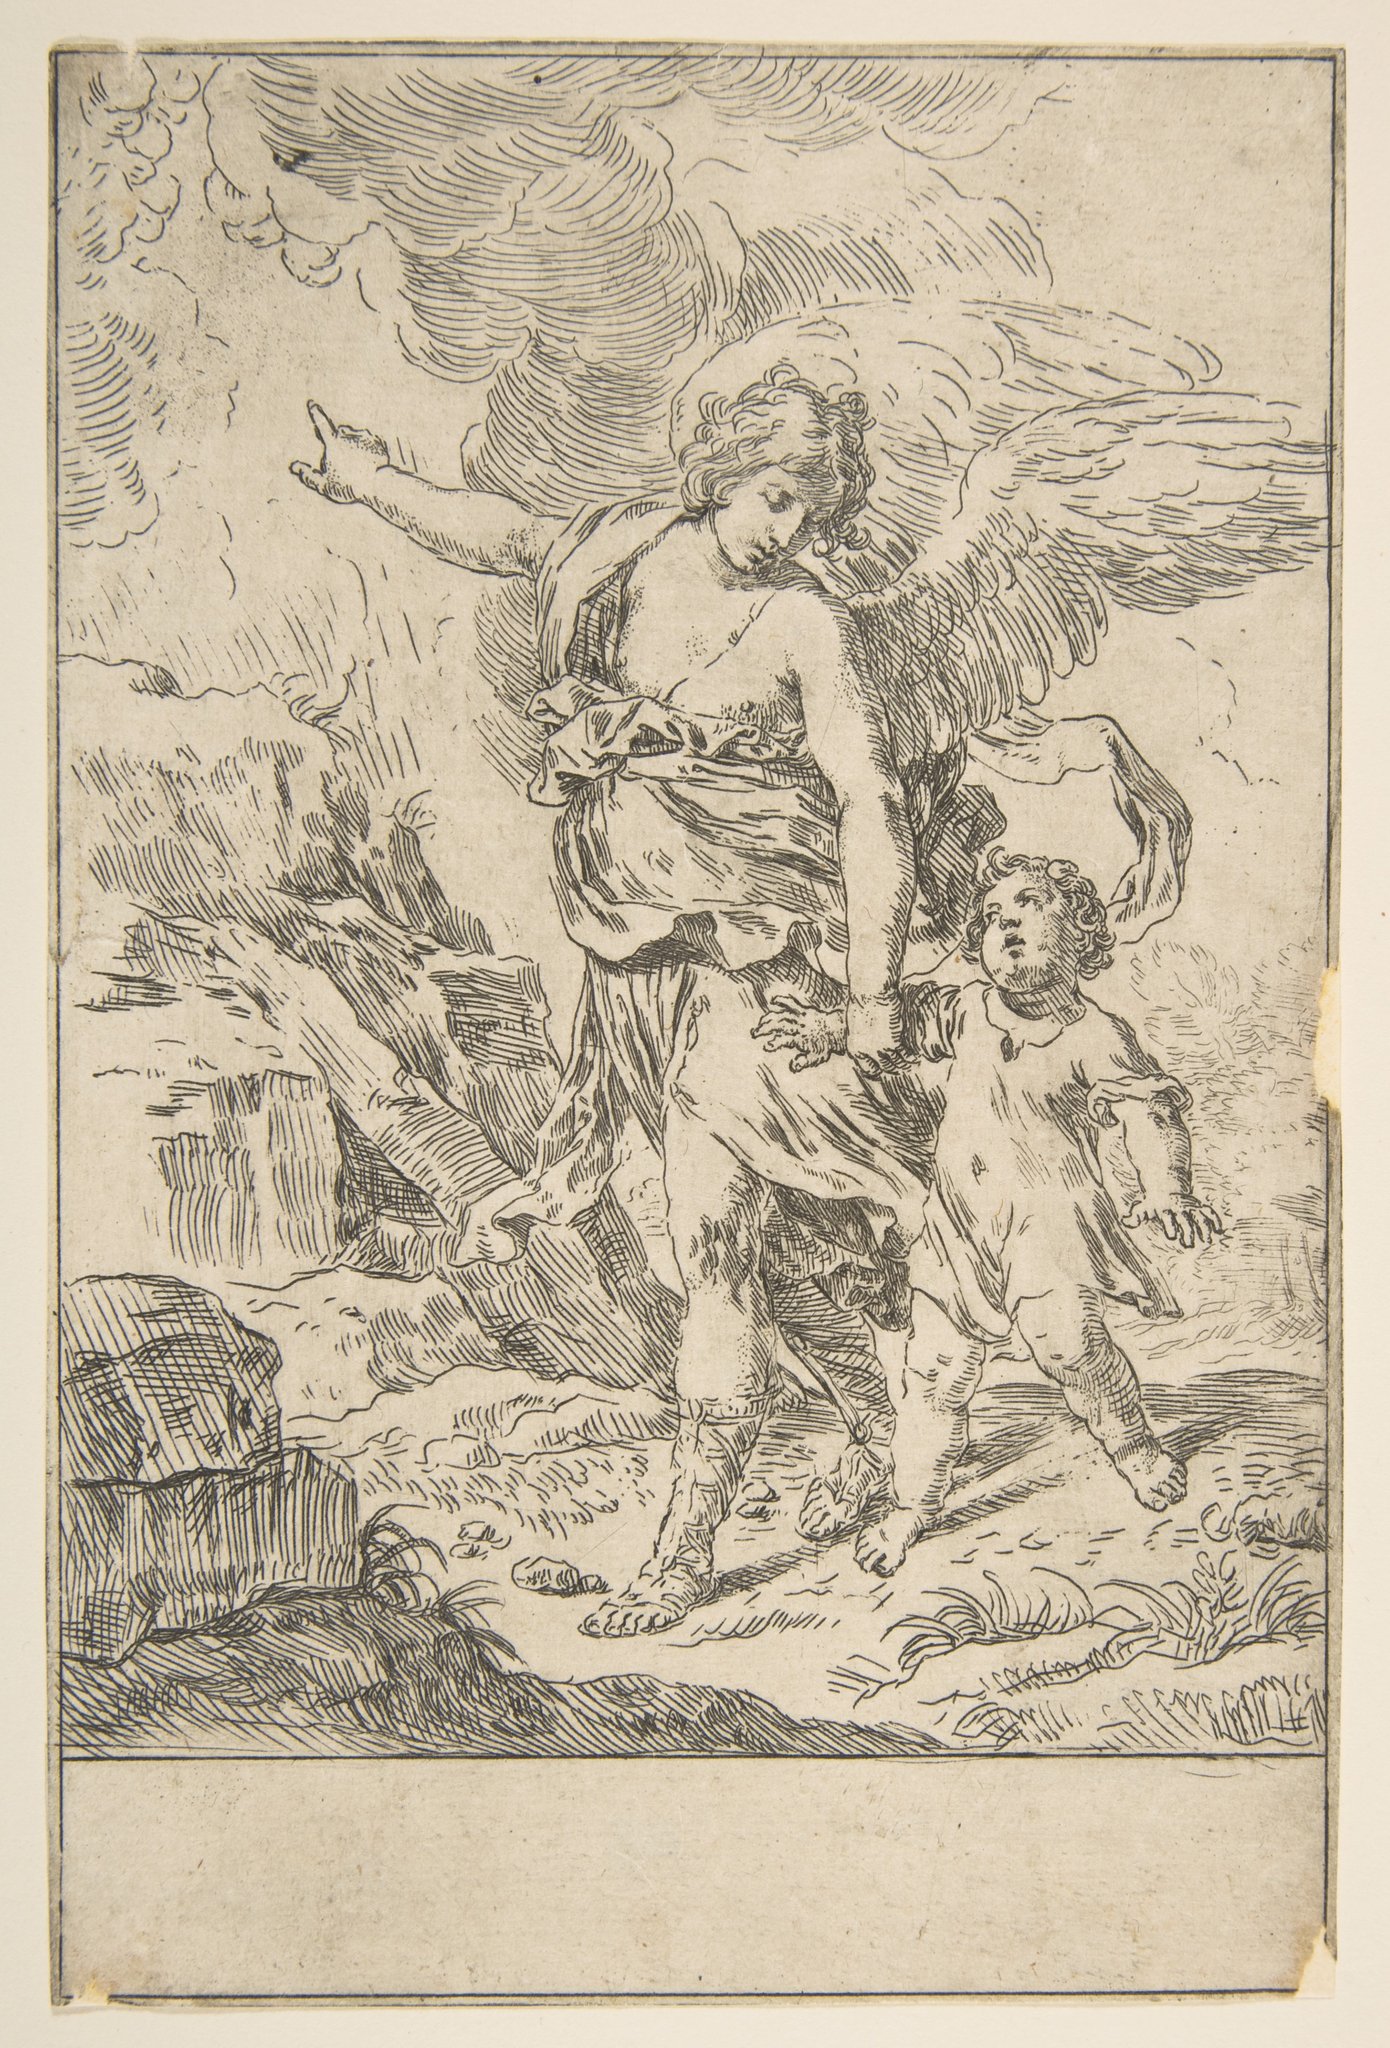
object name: print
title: A guardian angel walking with a child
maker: simone cantarini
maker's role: artist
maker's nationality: italian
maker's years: 1612-1648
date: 1640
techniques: etching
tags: children,walking,angels